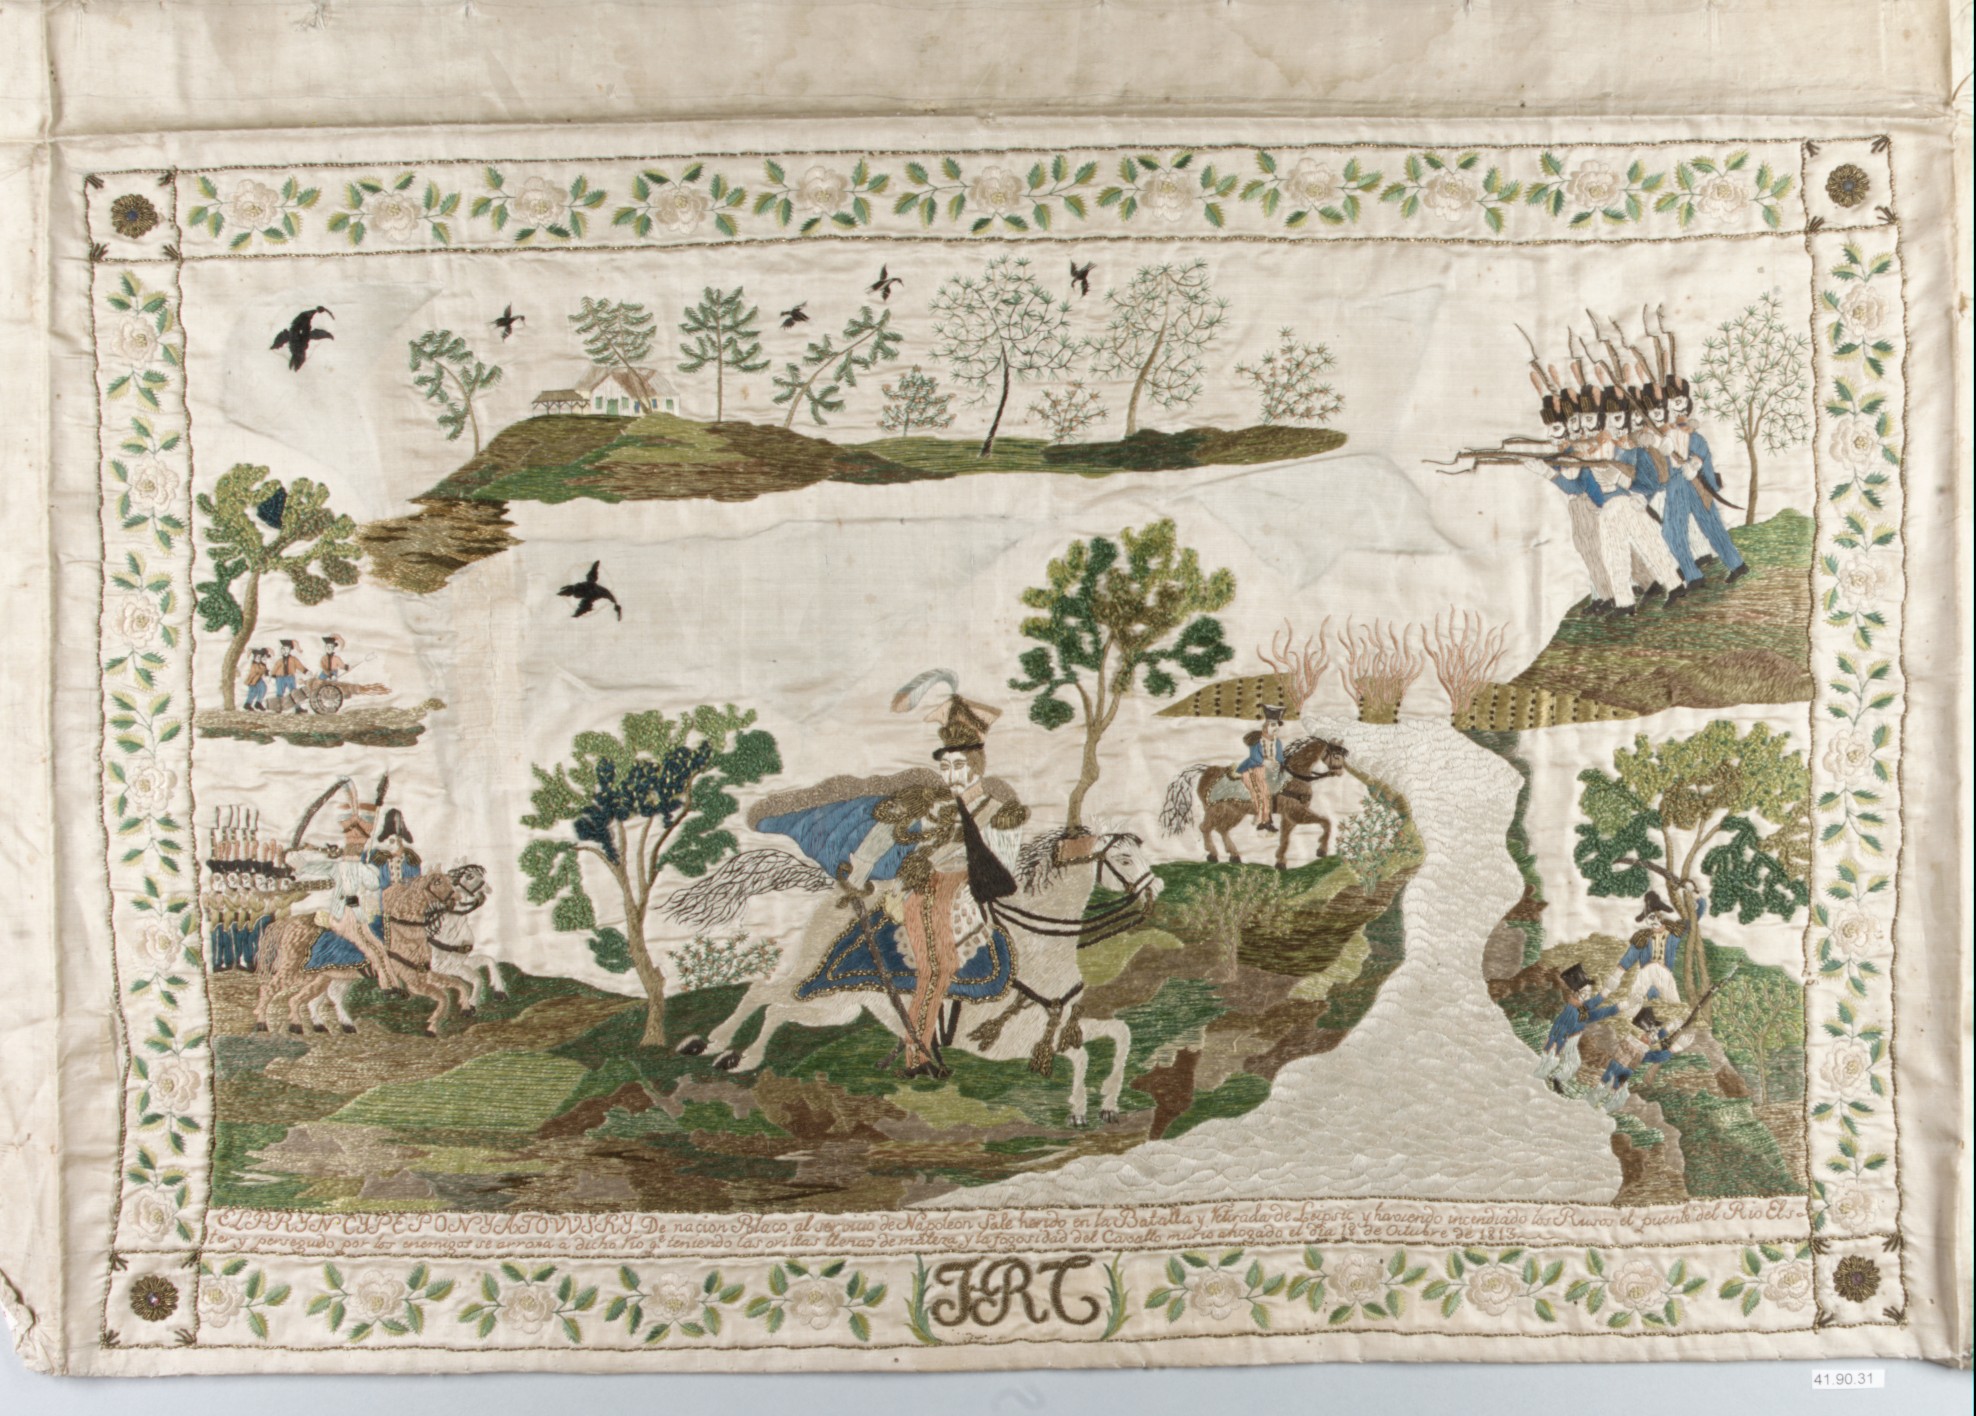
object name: embroidered picture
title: Death of Prince Joseph Poniatowski (1763–1813)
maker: horace vernet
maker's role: artist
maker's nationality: french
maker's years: 1789-1863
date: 1801-1833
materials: metal thread, silk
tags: birds,bow and arrow,horses,trees